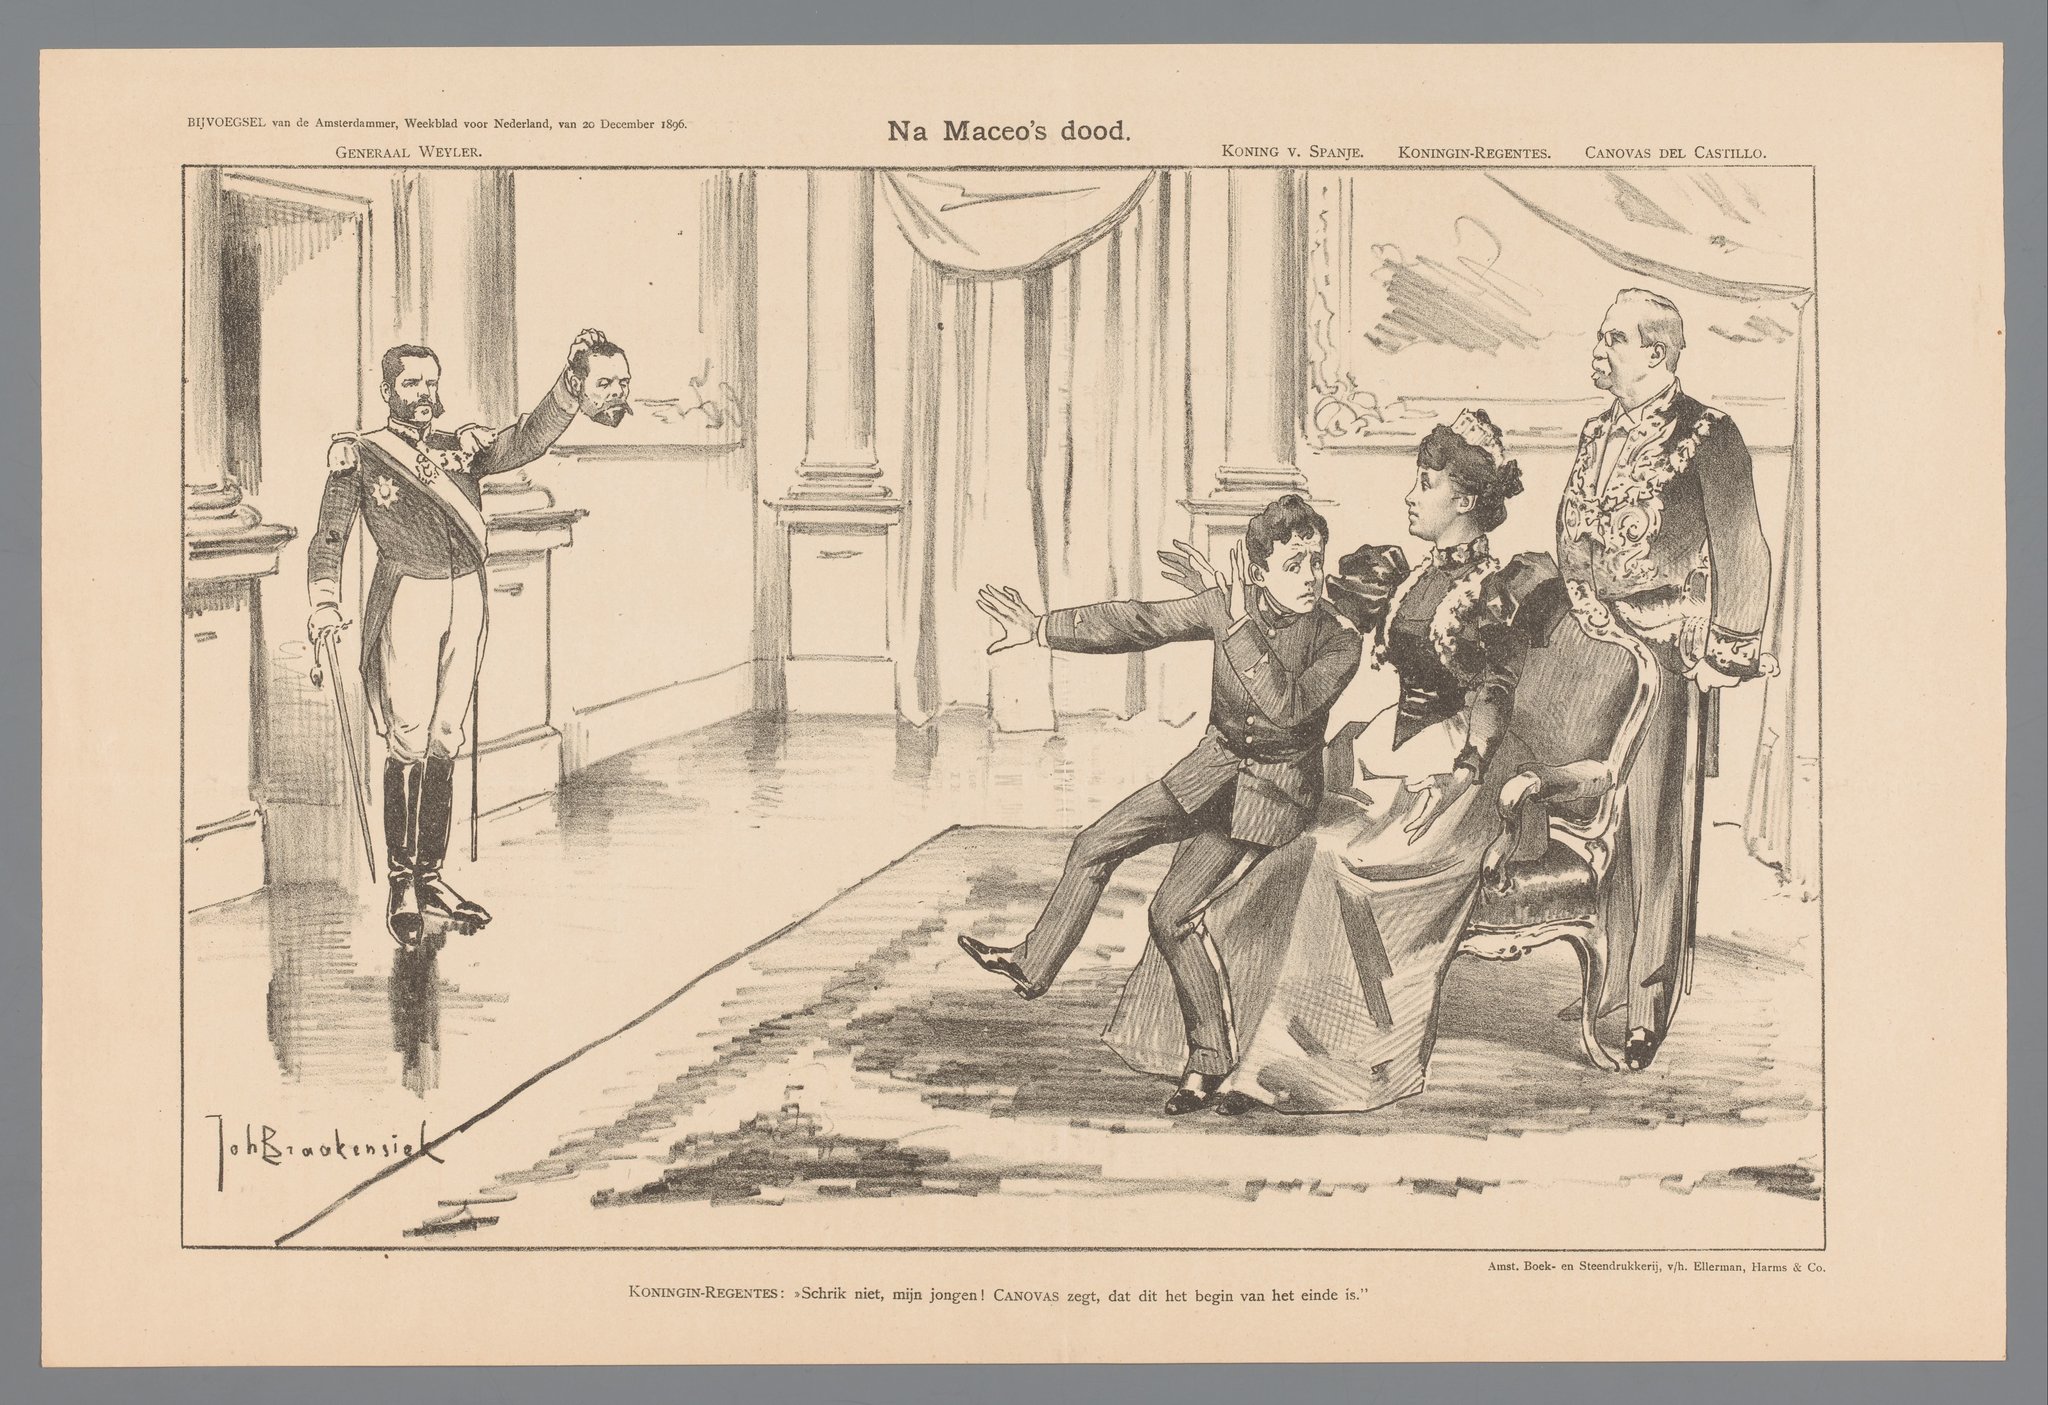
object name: cartoon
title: Na Maceo's dood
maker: johan braakensiek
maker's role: draughtsman, print maker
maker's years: 1858-1940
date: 1896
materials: paper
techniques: lithograph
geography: amsterdam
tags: politician, head of a beheaded person, political caricatures and satires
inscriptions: date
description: Prent uit het bijvoegsel van: De Amsterdammer. Weekblad voor Nederland, 20 december 1896.